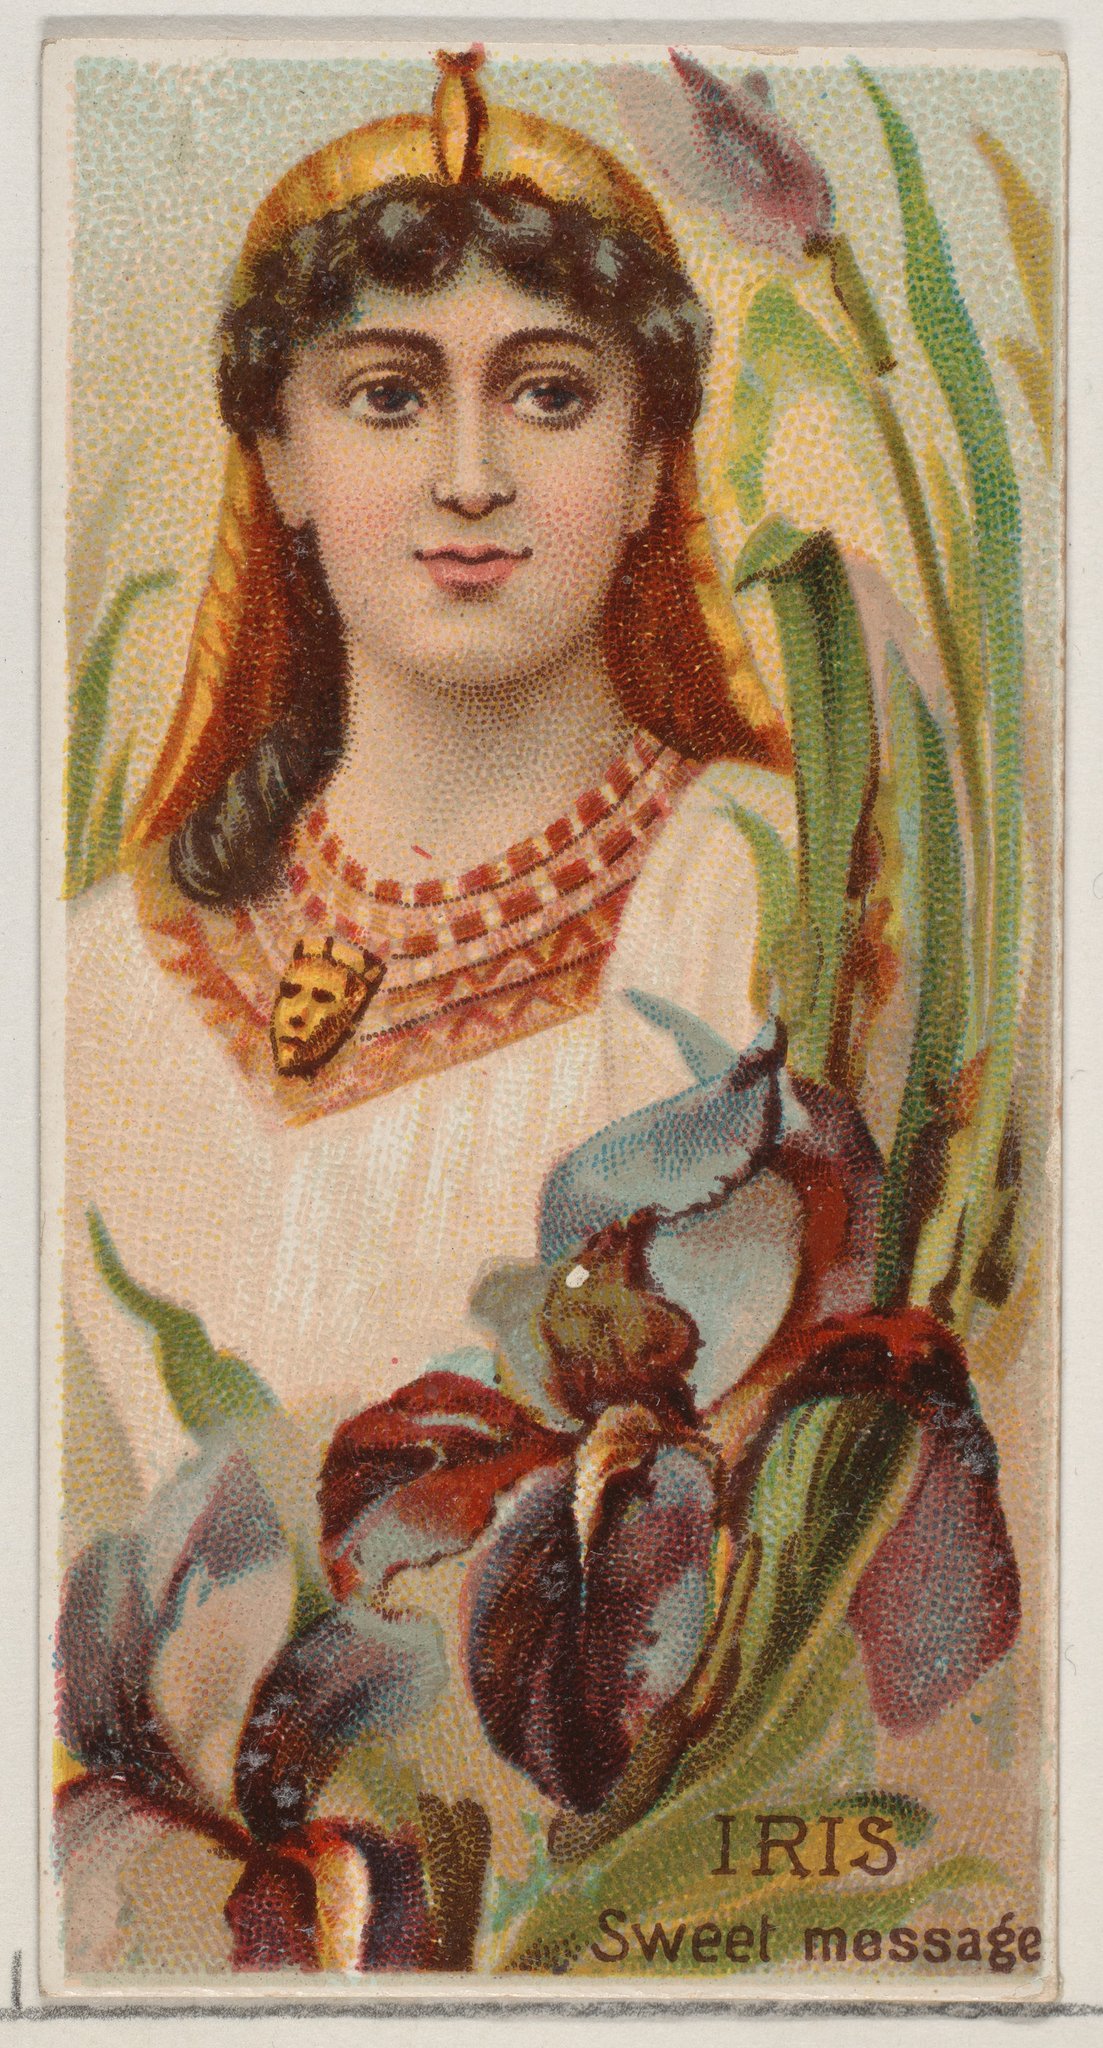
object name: print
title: Iris: Sweet Message, from the series Floral Beauties and Language of Flowers (N75) for Duke brand cigarettes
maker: american tobacco company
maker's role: publisher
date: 1892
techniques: color lithograph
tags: women,flowers